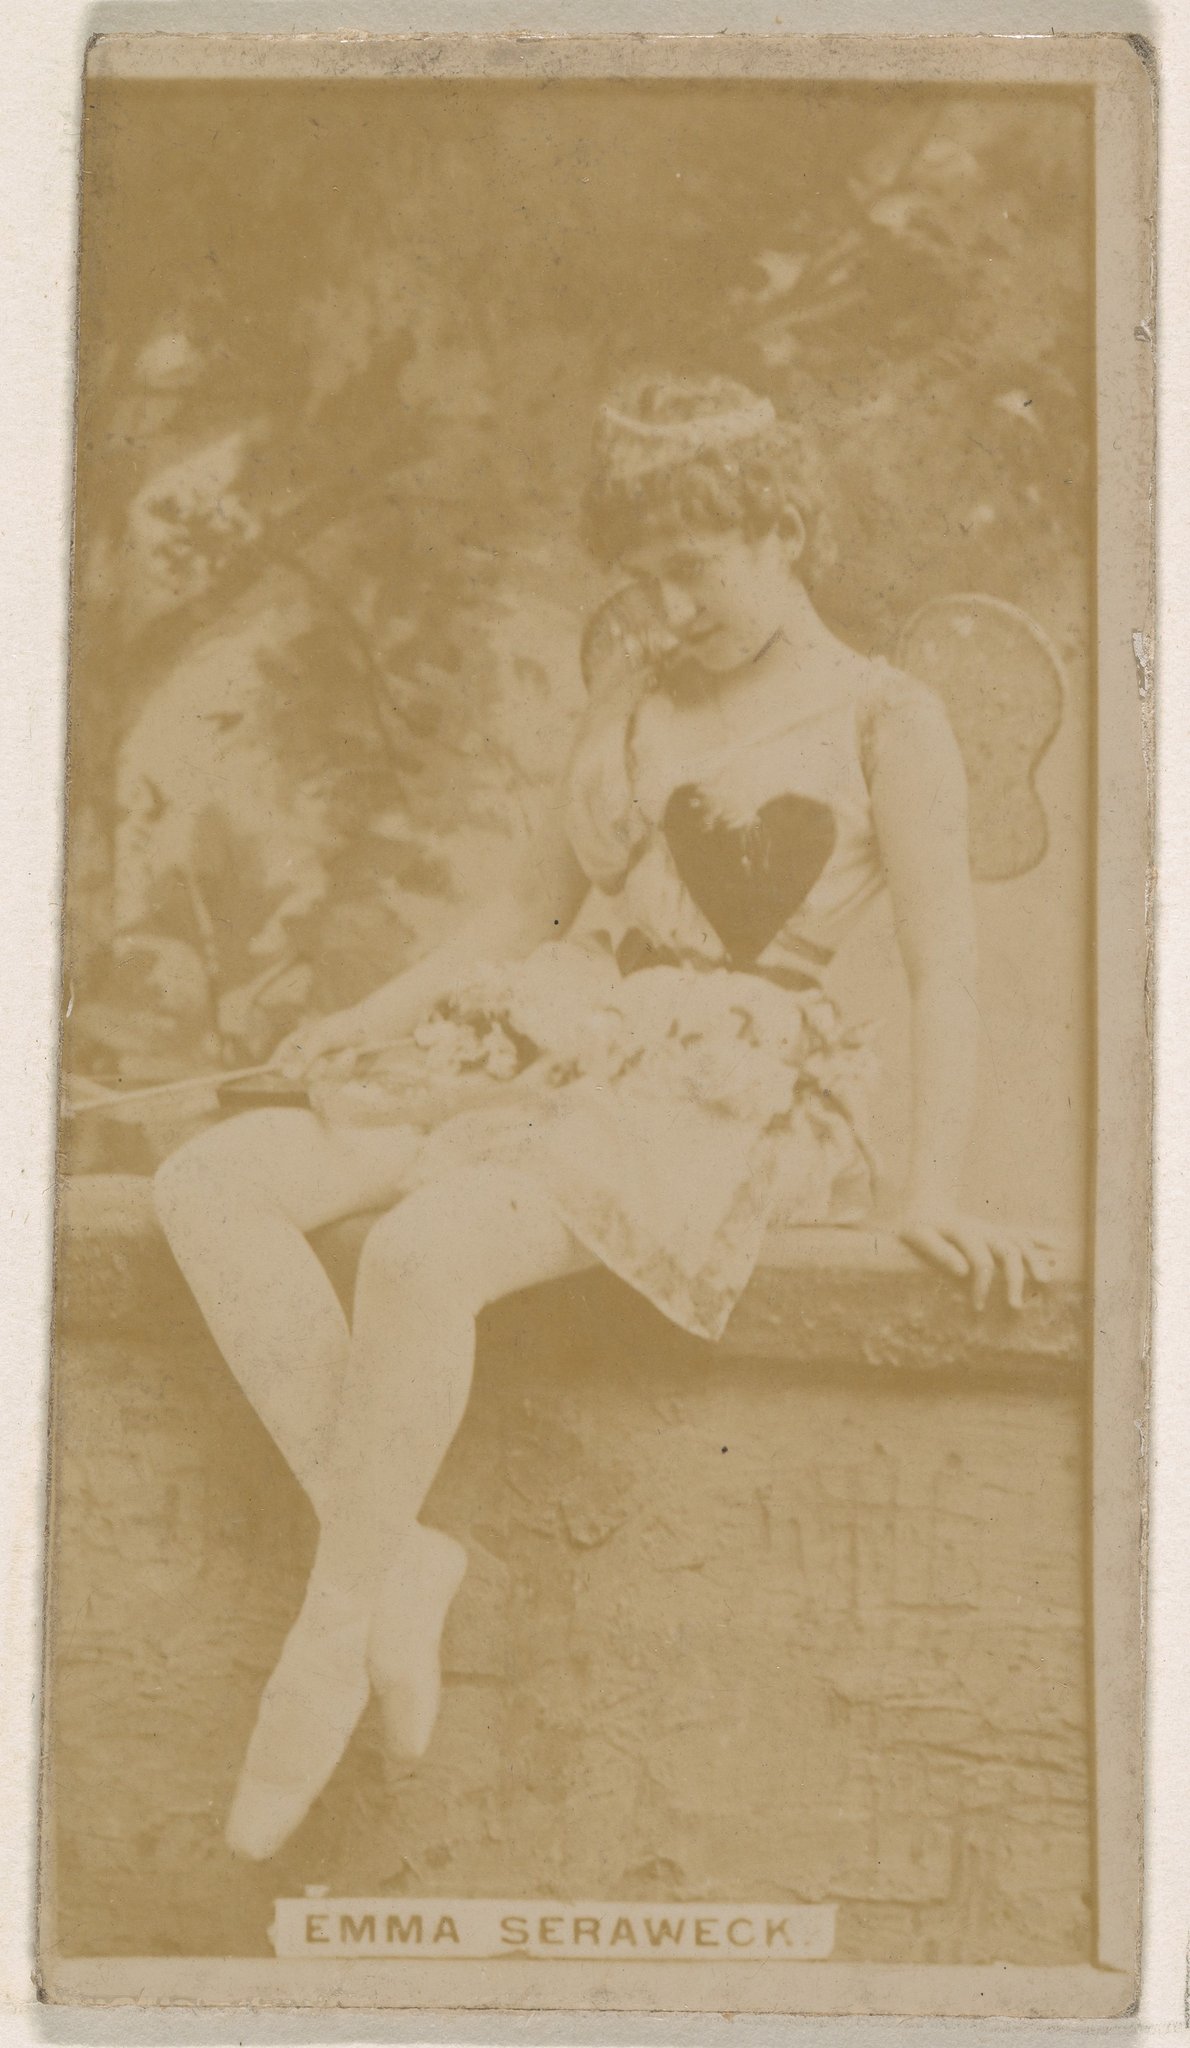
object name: photograph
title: Emma Seraweck, from the Actresses series (N245) issued by Kinney Brothers to promote Sweet Caporal Cigarettes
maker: kinney brothers tobacco company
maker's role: publisher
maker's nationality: american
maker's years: 1869-2011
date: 1890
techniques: albumen silver print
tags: portraits,women,actresses